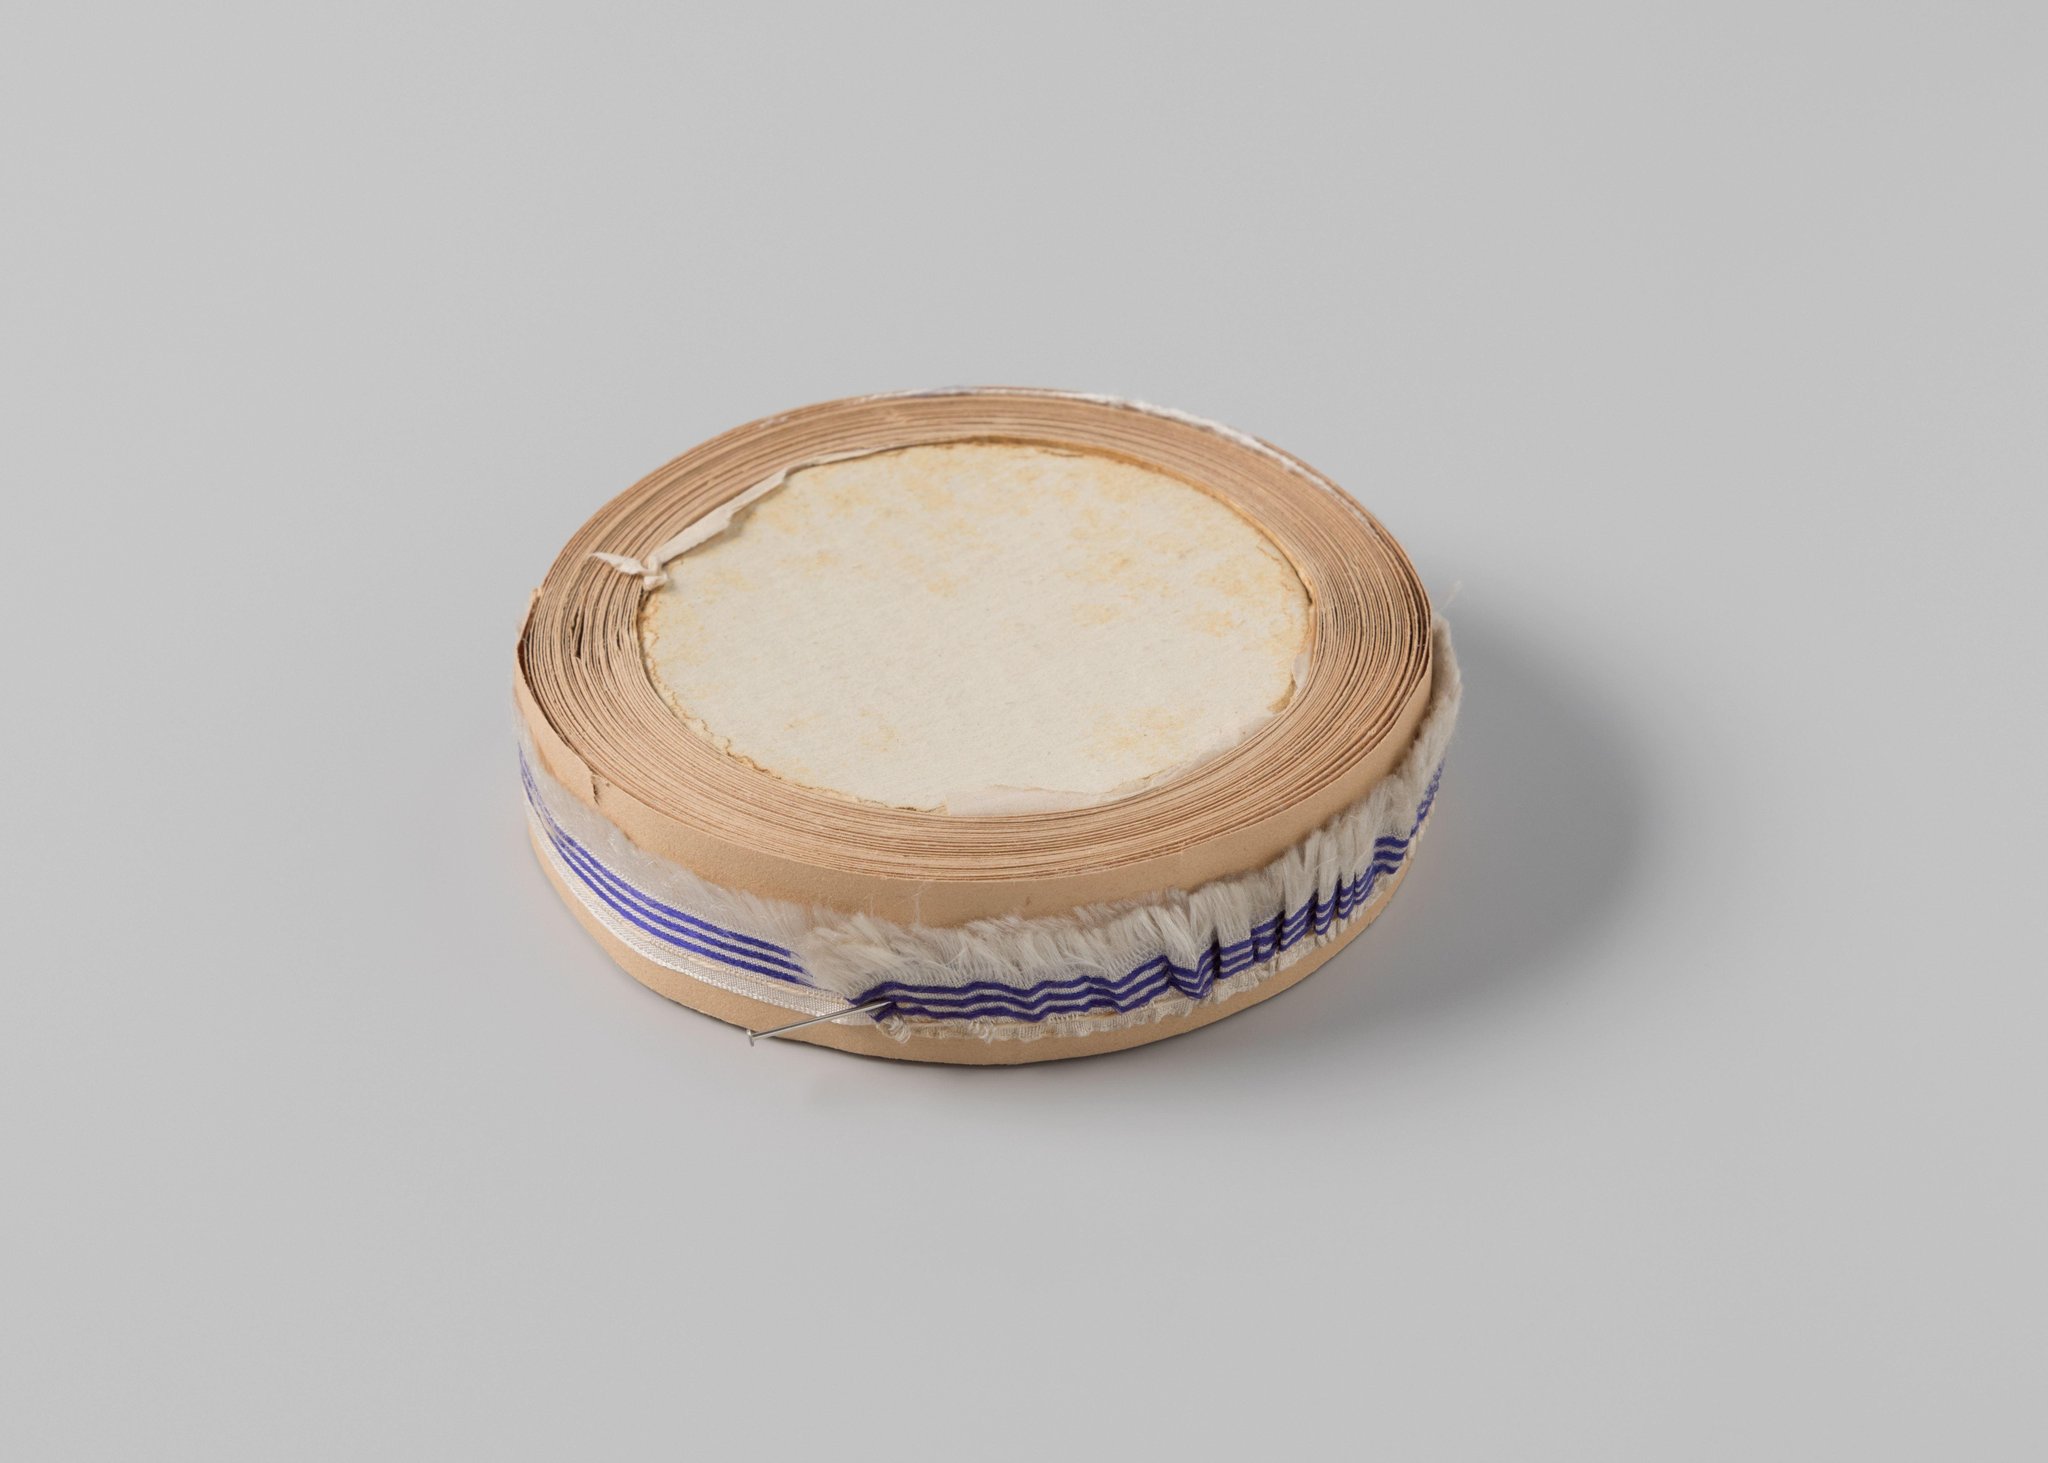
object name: braid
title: Rol met wit lint met één gerafelde zijde en drie blauwe horizontale strepen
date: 1930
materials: cardboard, paper, textile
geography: nijmegen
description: Rol met wit lint met één gerafelde zijde en drie blauwe horizontale strepen.